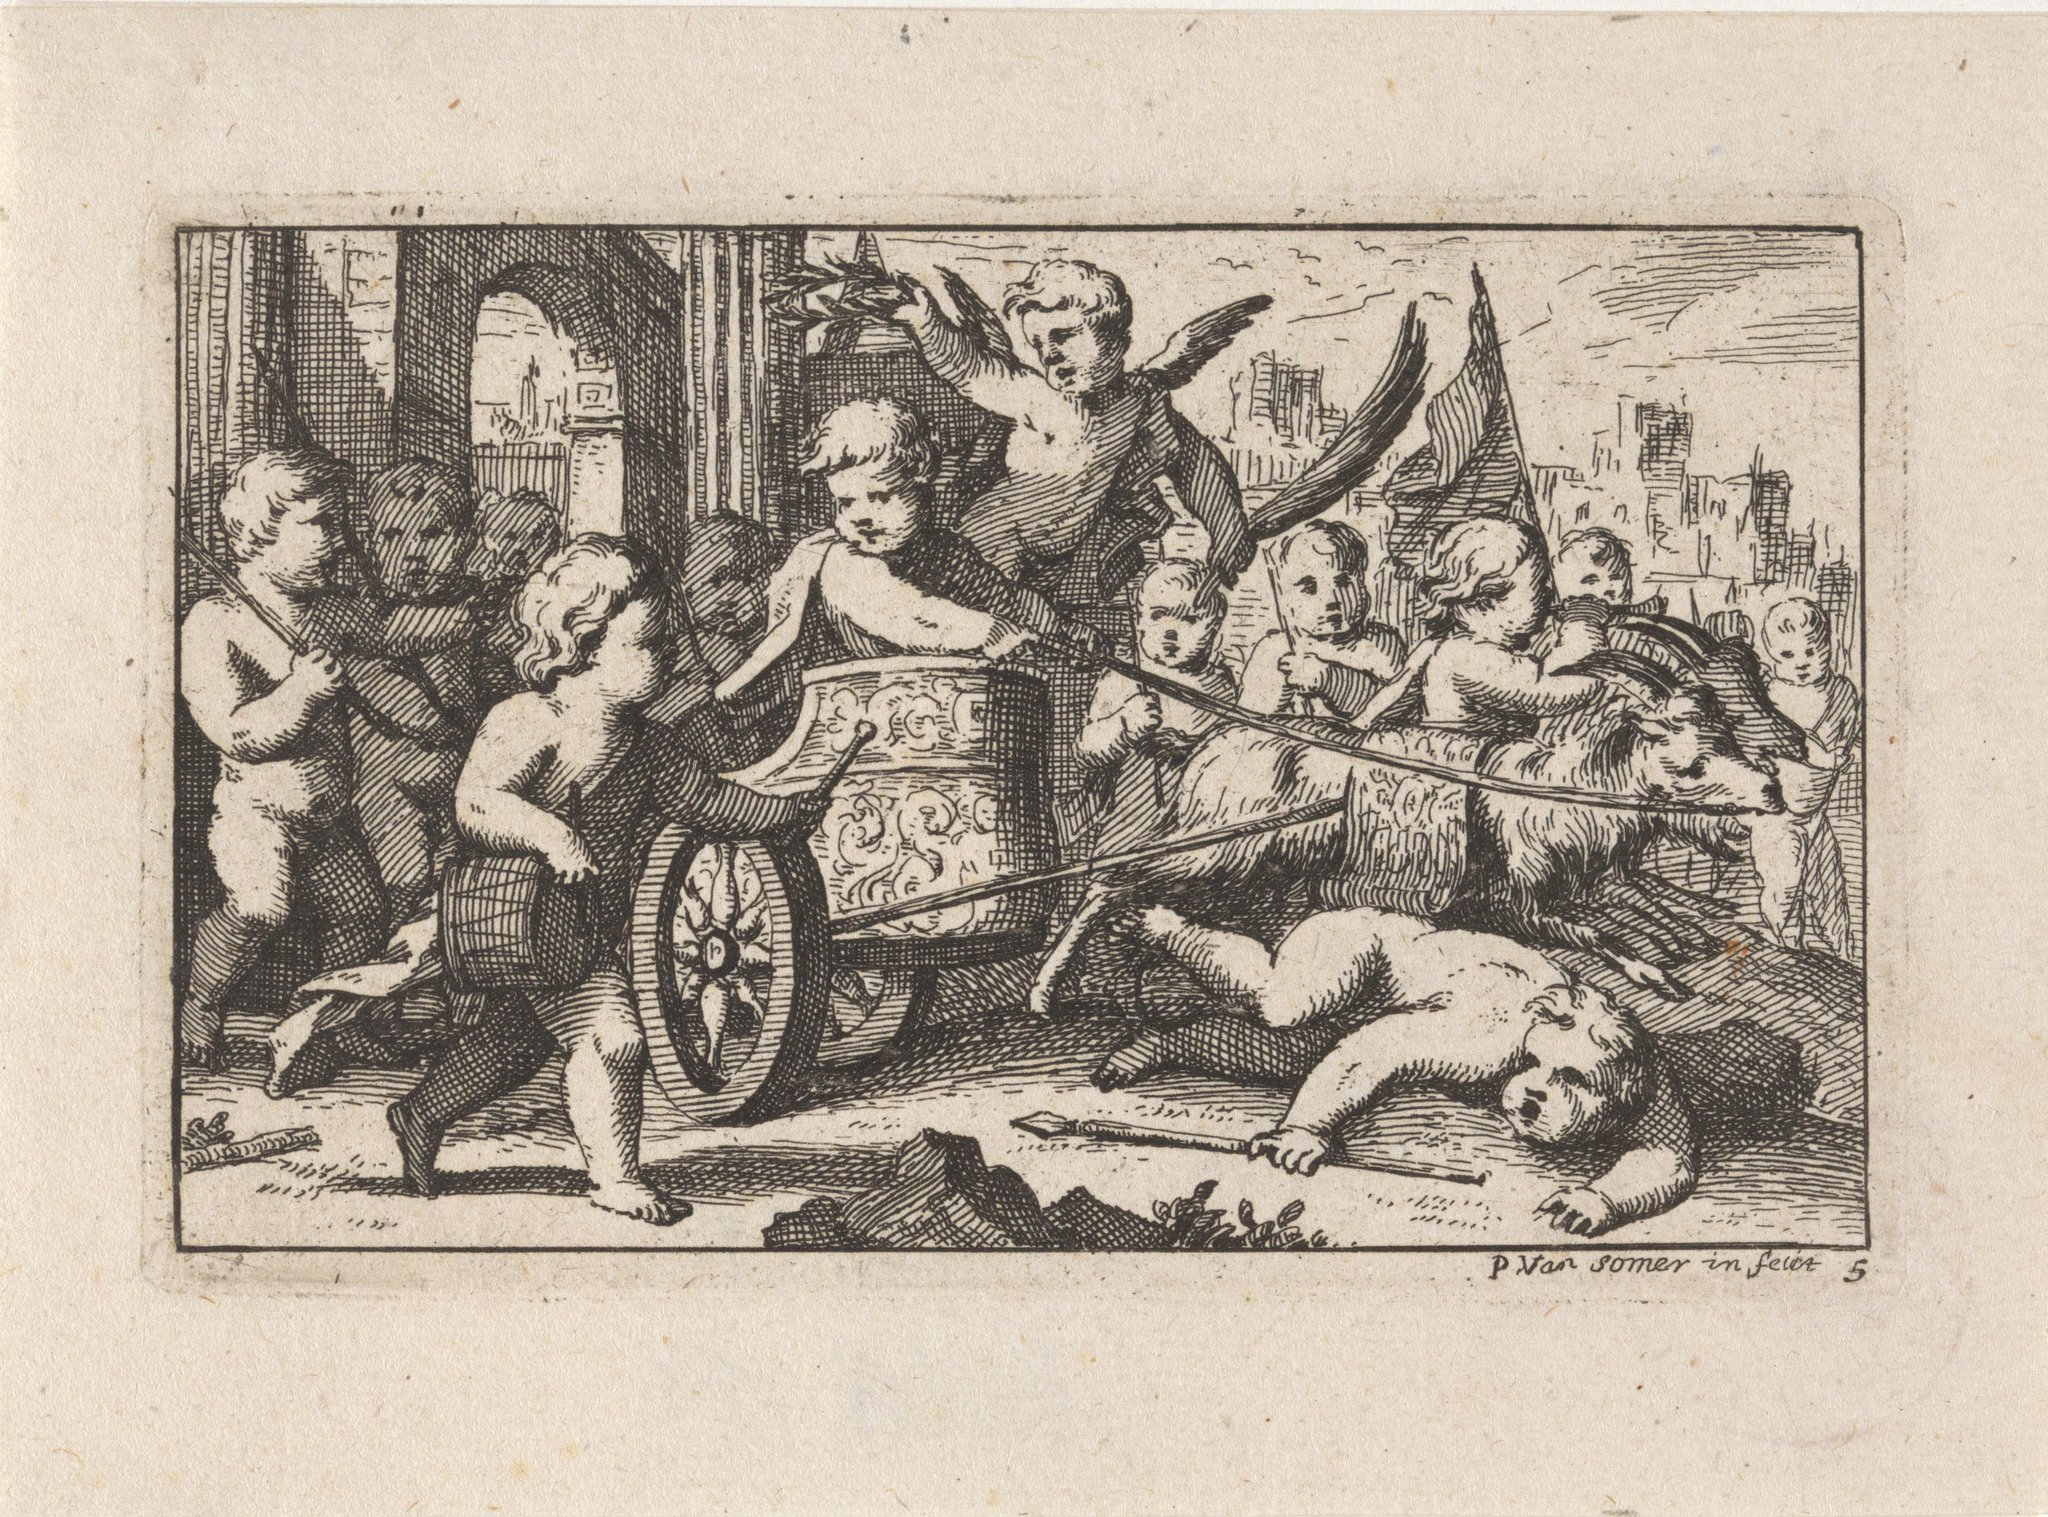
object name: print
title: Spelende putti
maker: paul van somer (ii)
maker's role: draughtsman, print maker, publisher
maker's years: 1639-1704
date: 1670-1697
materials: paper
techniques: etching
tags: goat, cupids: 'amores', 'amoretti', 'putti', roman chariot, quadriga ~ triumph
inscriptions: collector's mark: Lugt 240, number: ‘No. 88’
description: Een grote groep putti kijkt toe hoe een putto voorbij rijdt in een met twee bokken bespannen wagen. Een languit op de grond gevallen putto probeert op tijd te ontsnappen aan de aanstormende wagen. Een van de putti houdt de putto in de wagen een lauwerkrans boven het hoofd. Op de voorgrond loopt een putto met een trommel.